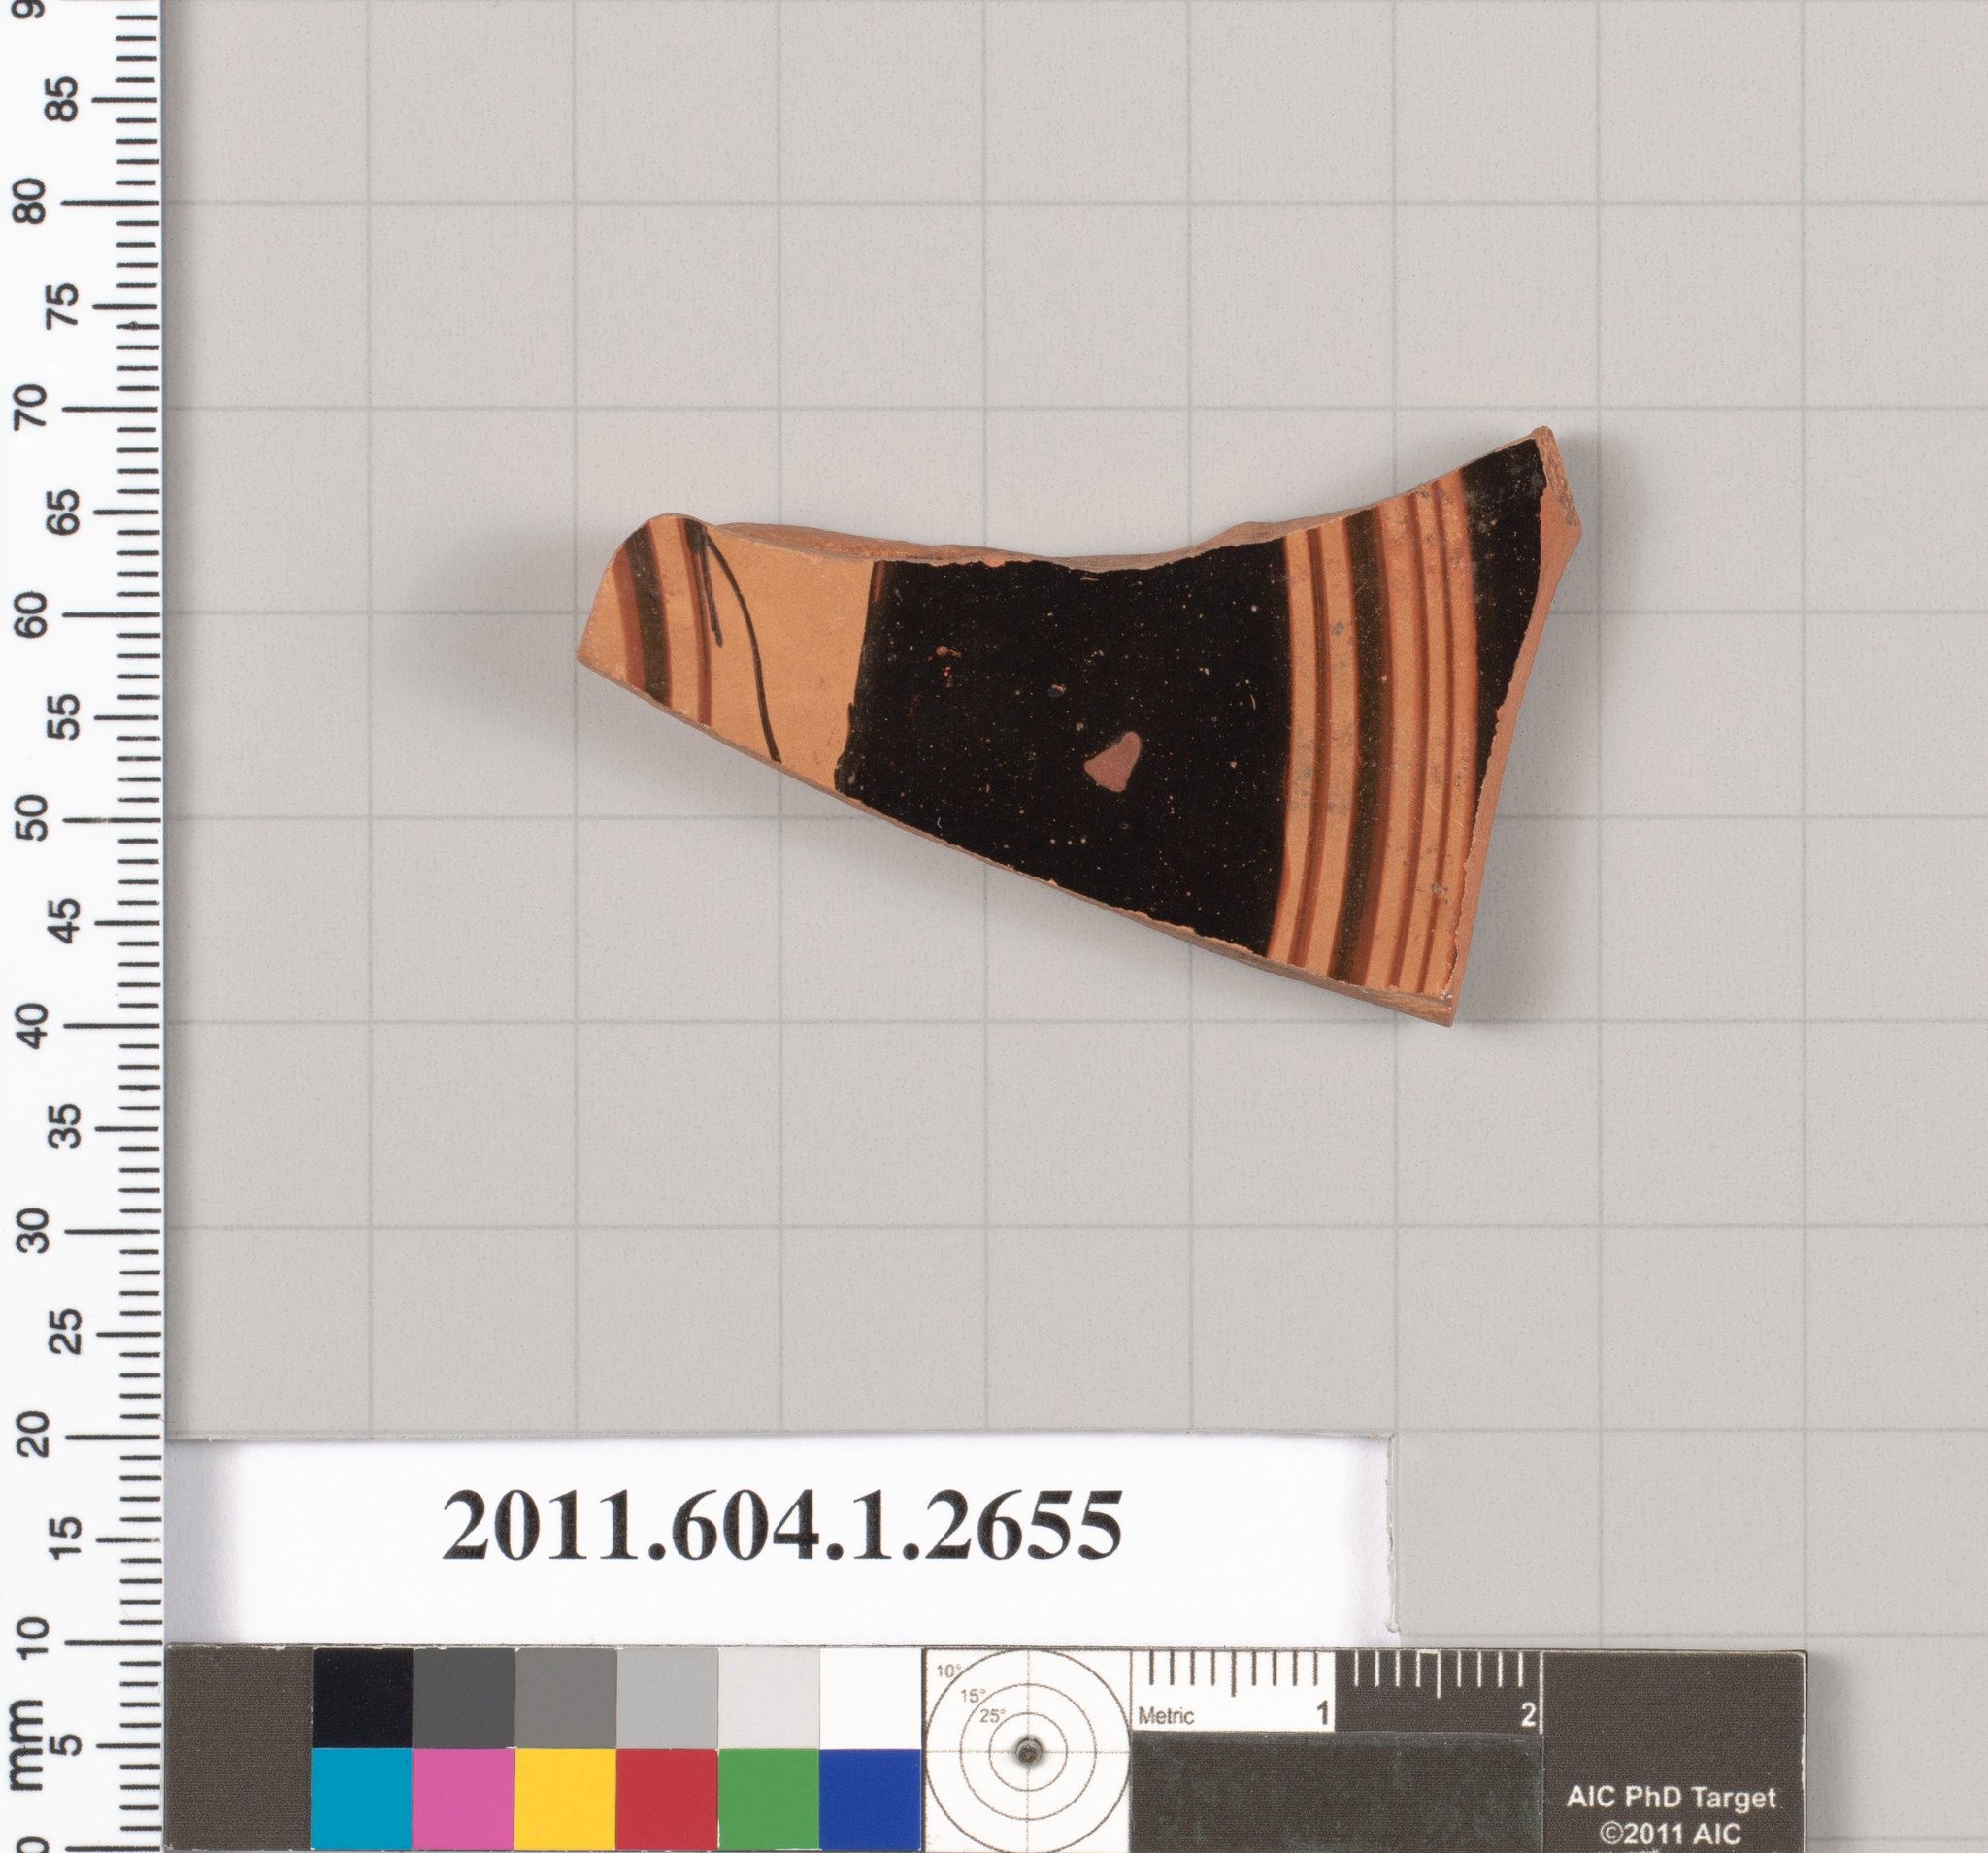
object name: kylix fragment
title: Terracotta fragment of a kylix (drinking cup)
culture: greek, attic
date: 500-451 BCE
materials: terracotta